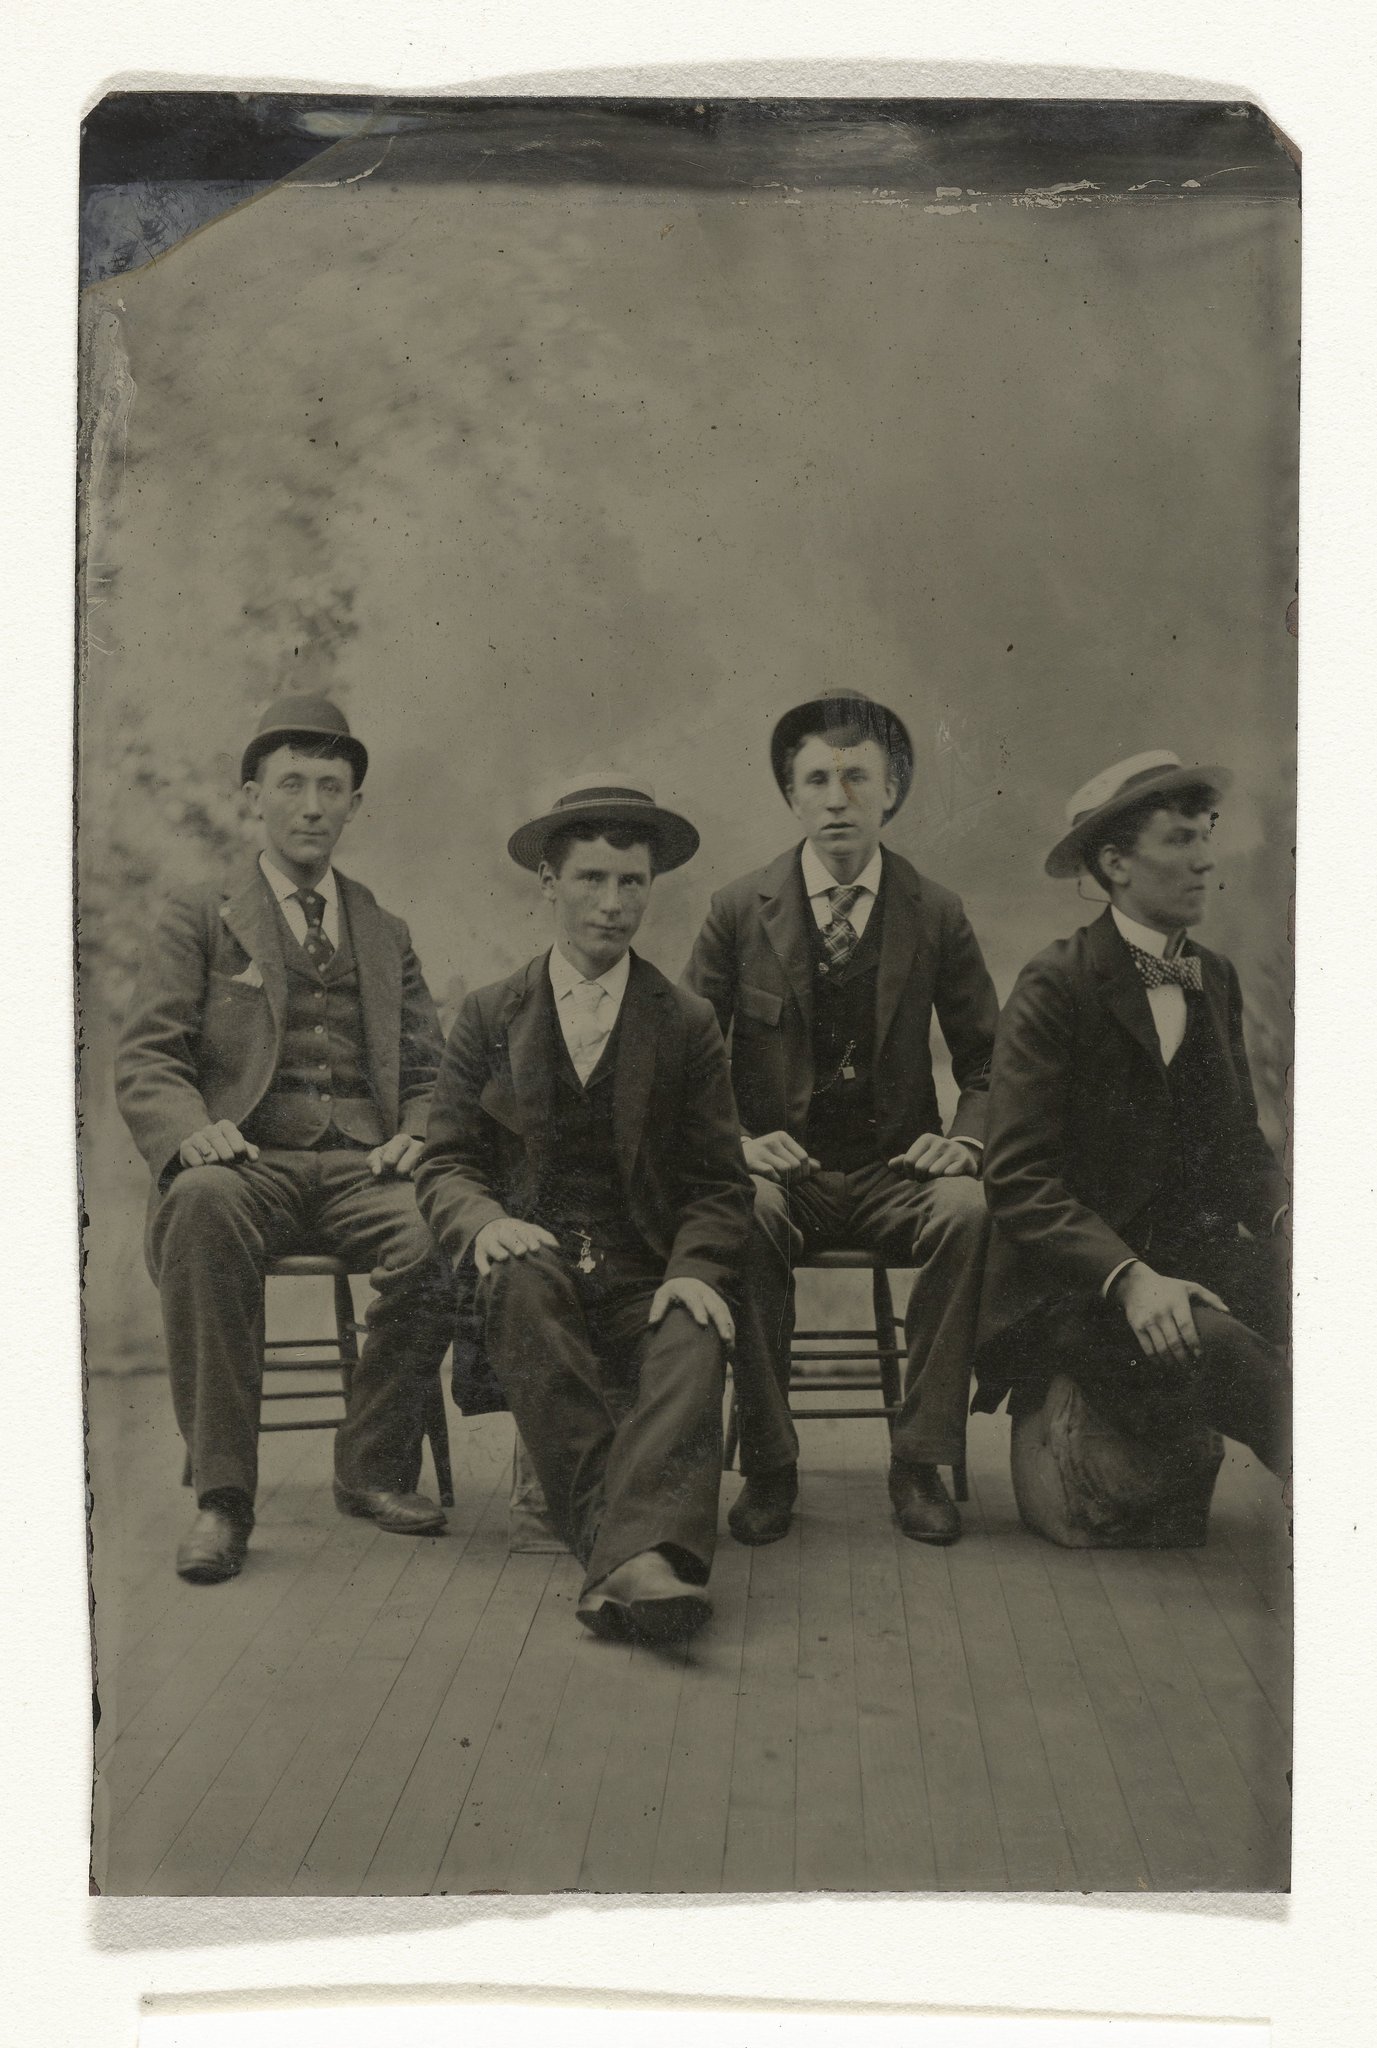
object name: photograph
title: Portret van vier mannen met hoeden, zittend in een atelier met geschilderd achtergronddoek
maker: Anonymous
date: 1880-1910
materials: metal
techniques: ferrotyping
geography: united states